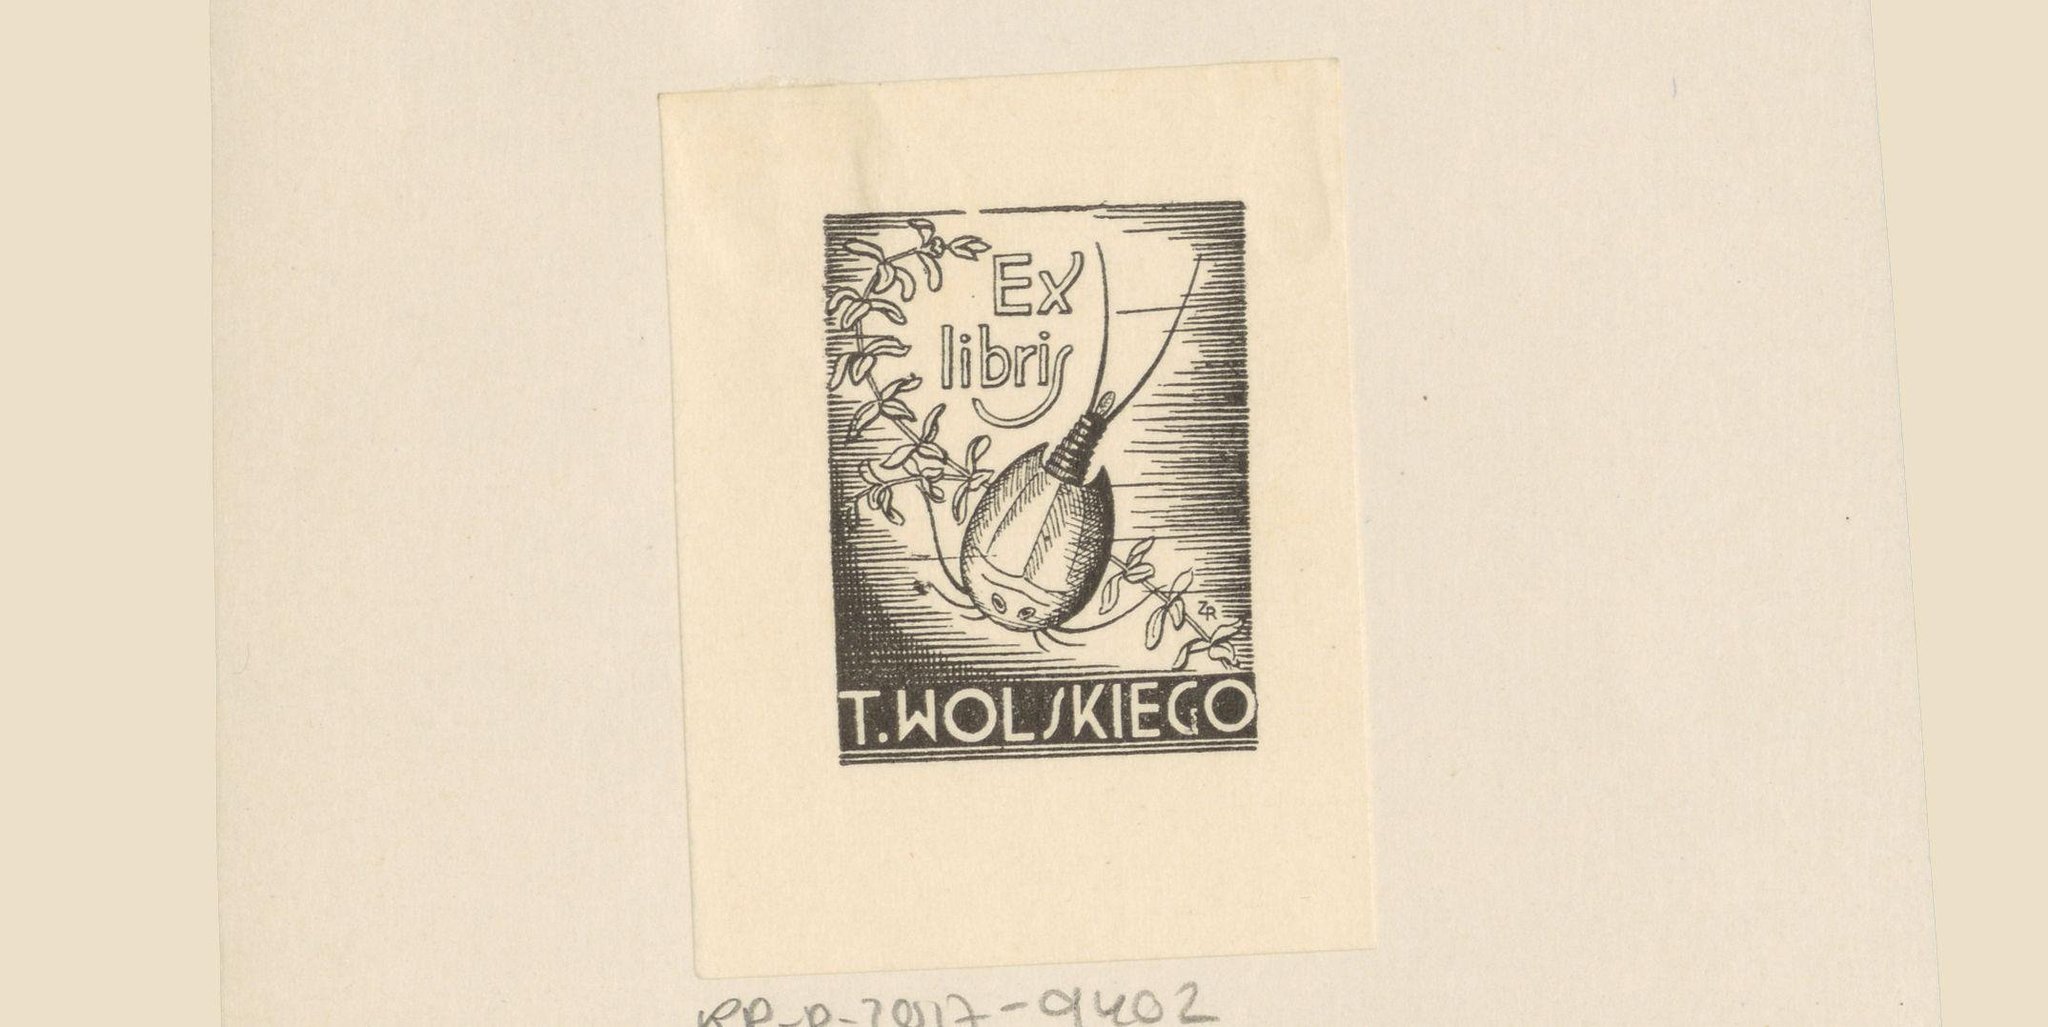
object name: bookplate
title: Ex libris van T. Wolski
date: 1900-1999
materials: paper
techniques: printing block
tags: insects